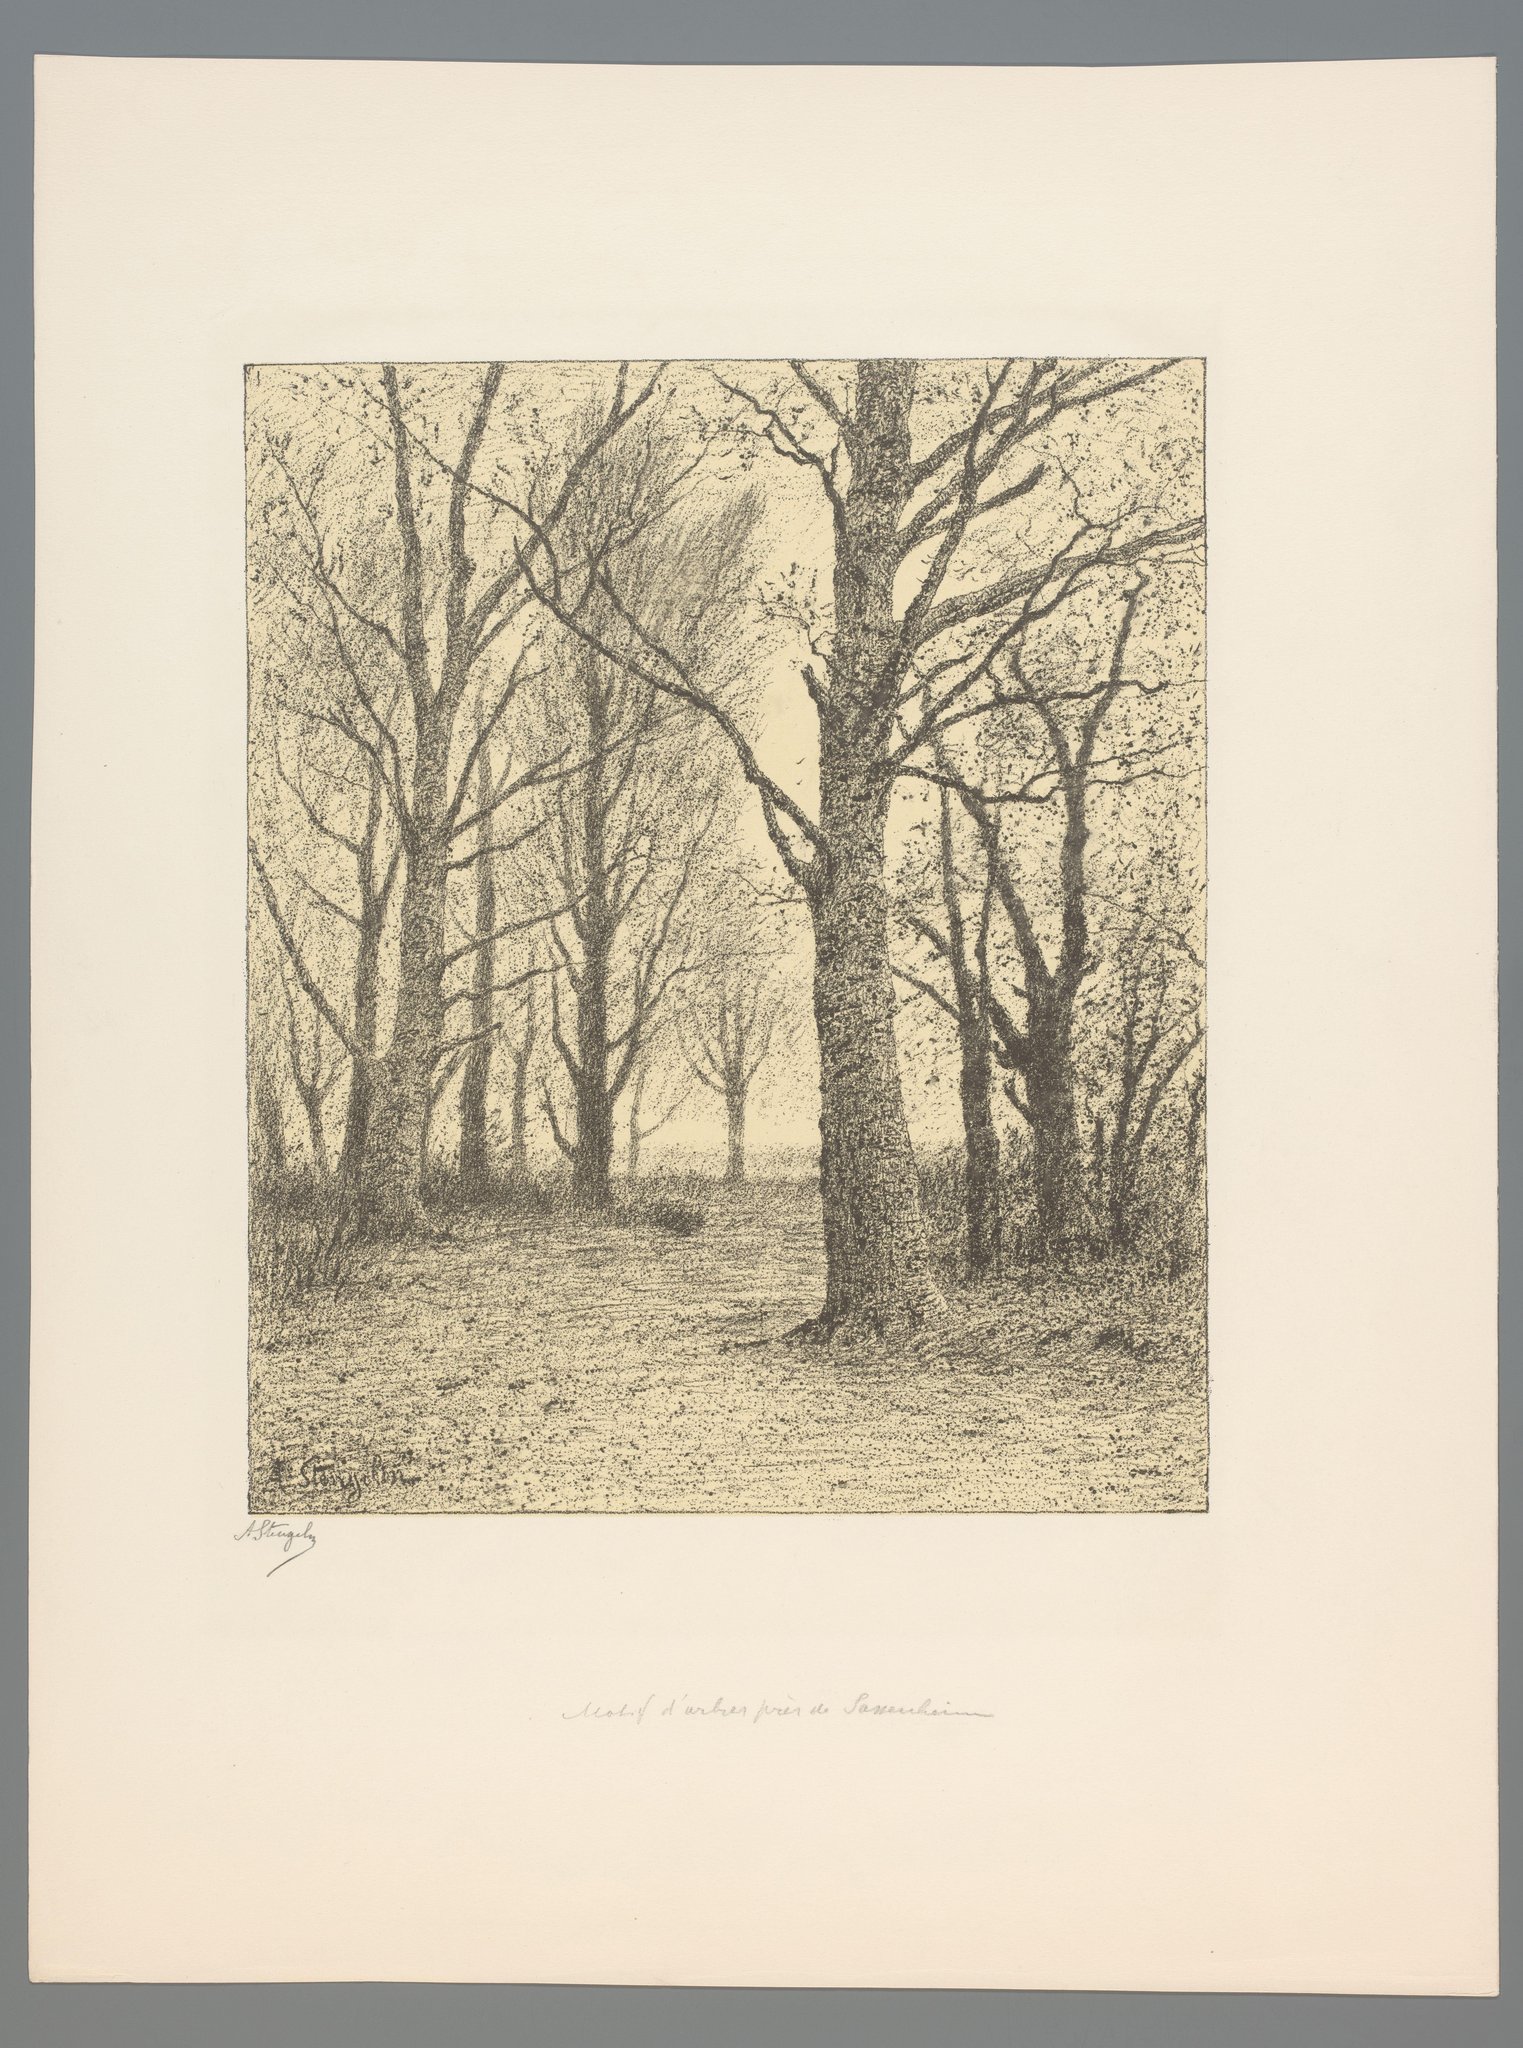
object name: print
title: Groep bomen bij Sassenheim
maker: alphonse stengelin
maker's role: painter, print maker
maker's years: 1852-1938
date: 1876-1910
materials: paper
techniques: tone lithography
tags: groups of trees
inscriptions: collector's mark: Lugt 2228